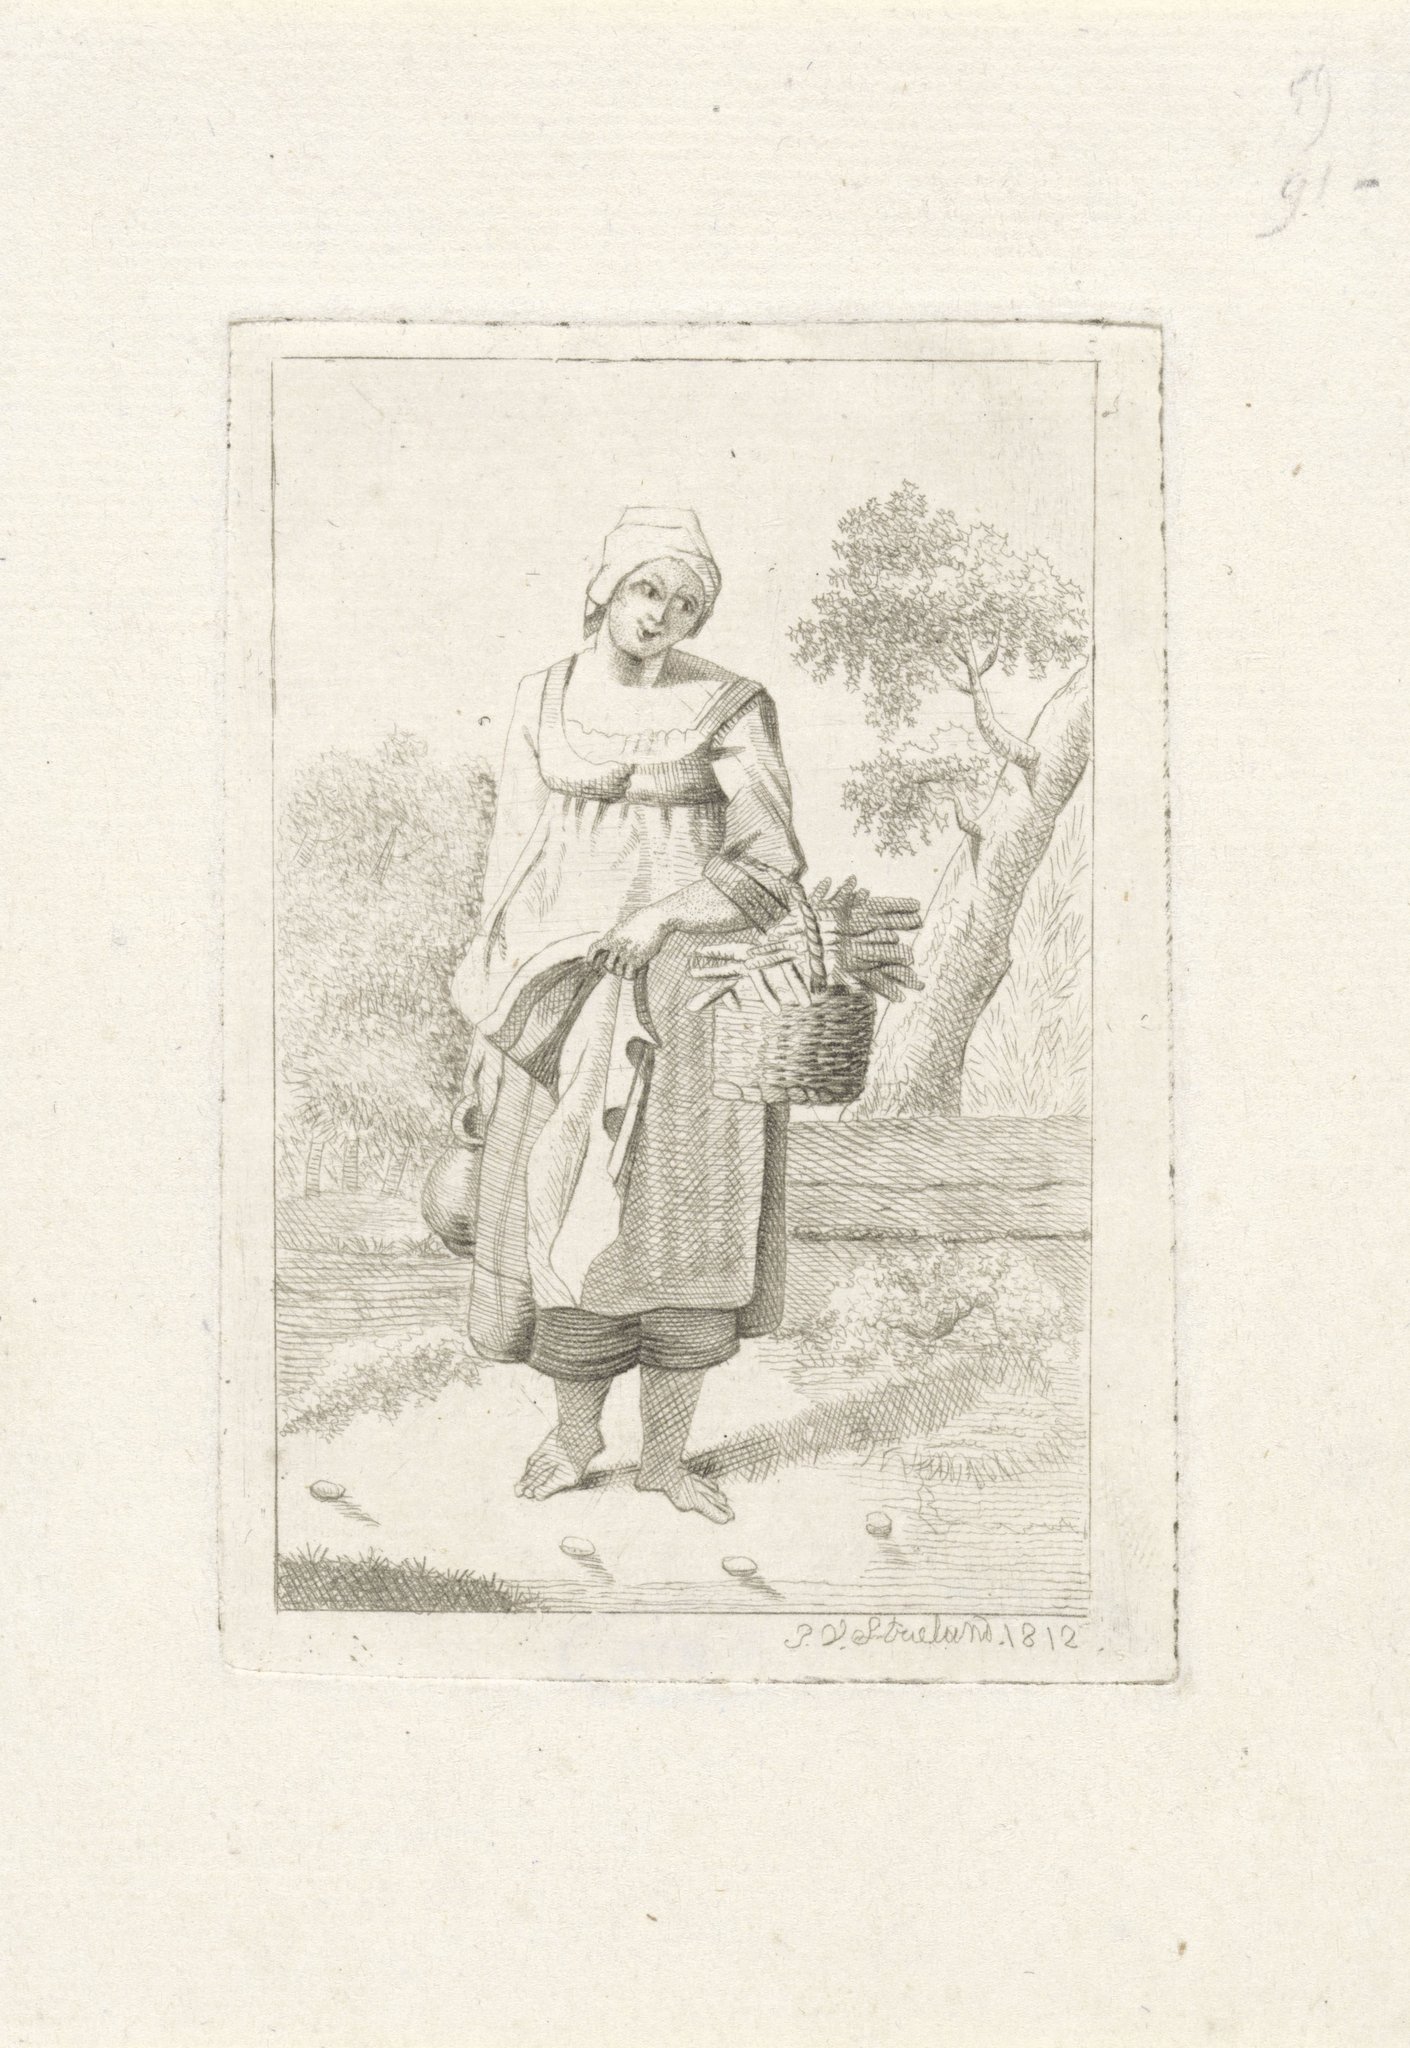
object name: print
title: Staande vrouw met een mand aan de arm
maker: j. van strieland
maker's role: print maker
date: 1812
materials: paper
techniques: engraving, etching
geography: netherlands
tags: container made of plant material other than wood: basket, standing figure - aa - female human figure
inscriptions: collector's mark: Lugt 2228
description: Een staande vrouw met een mand aan haar arm en een kan in haar andere hand.